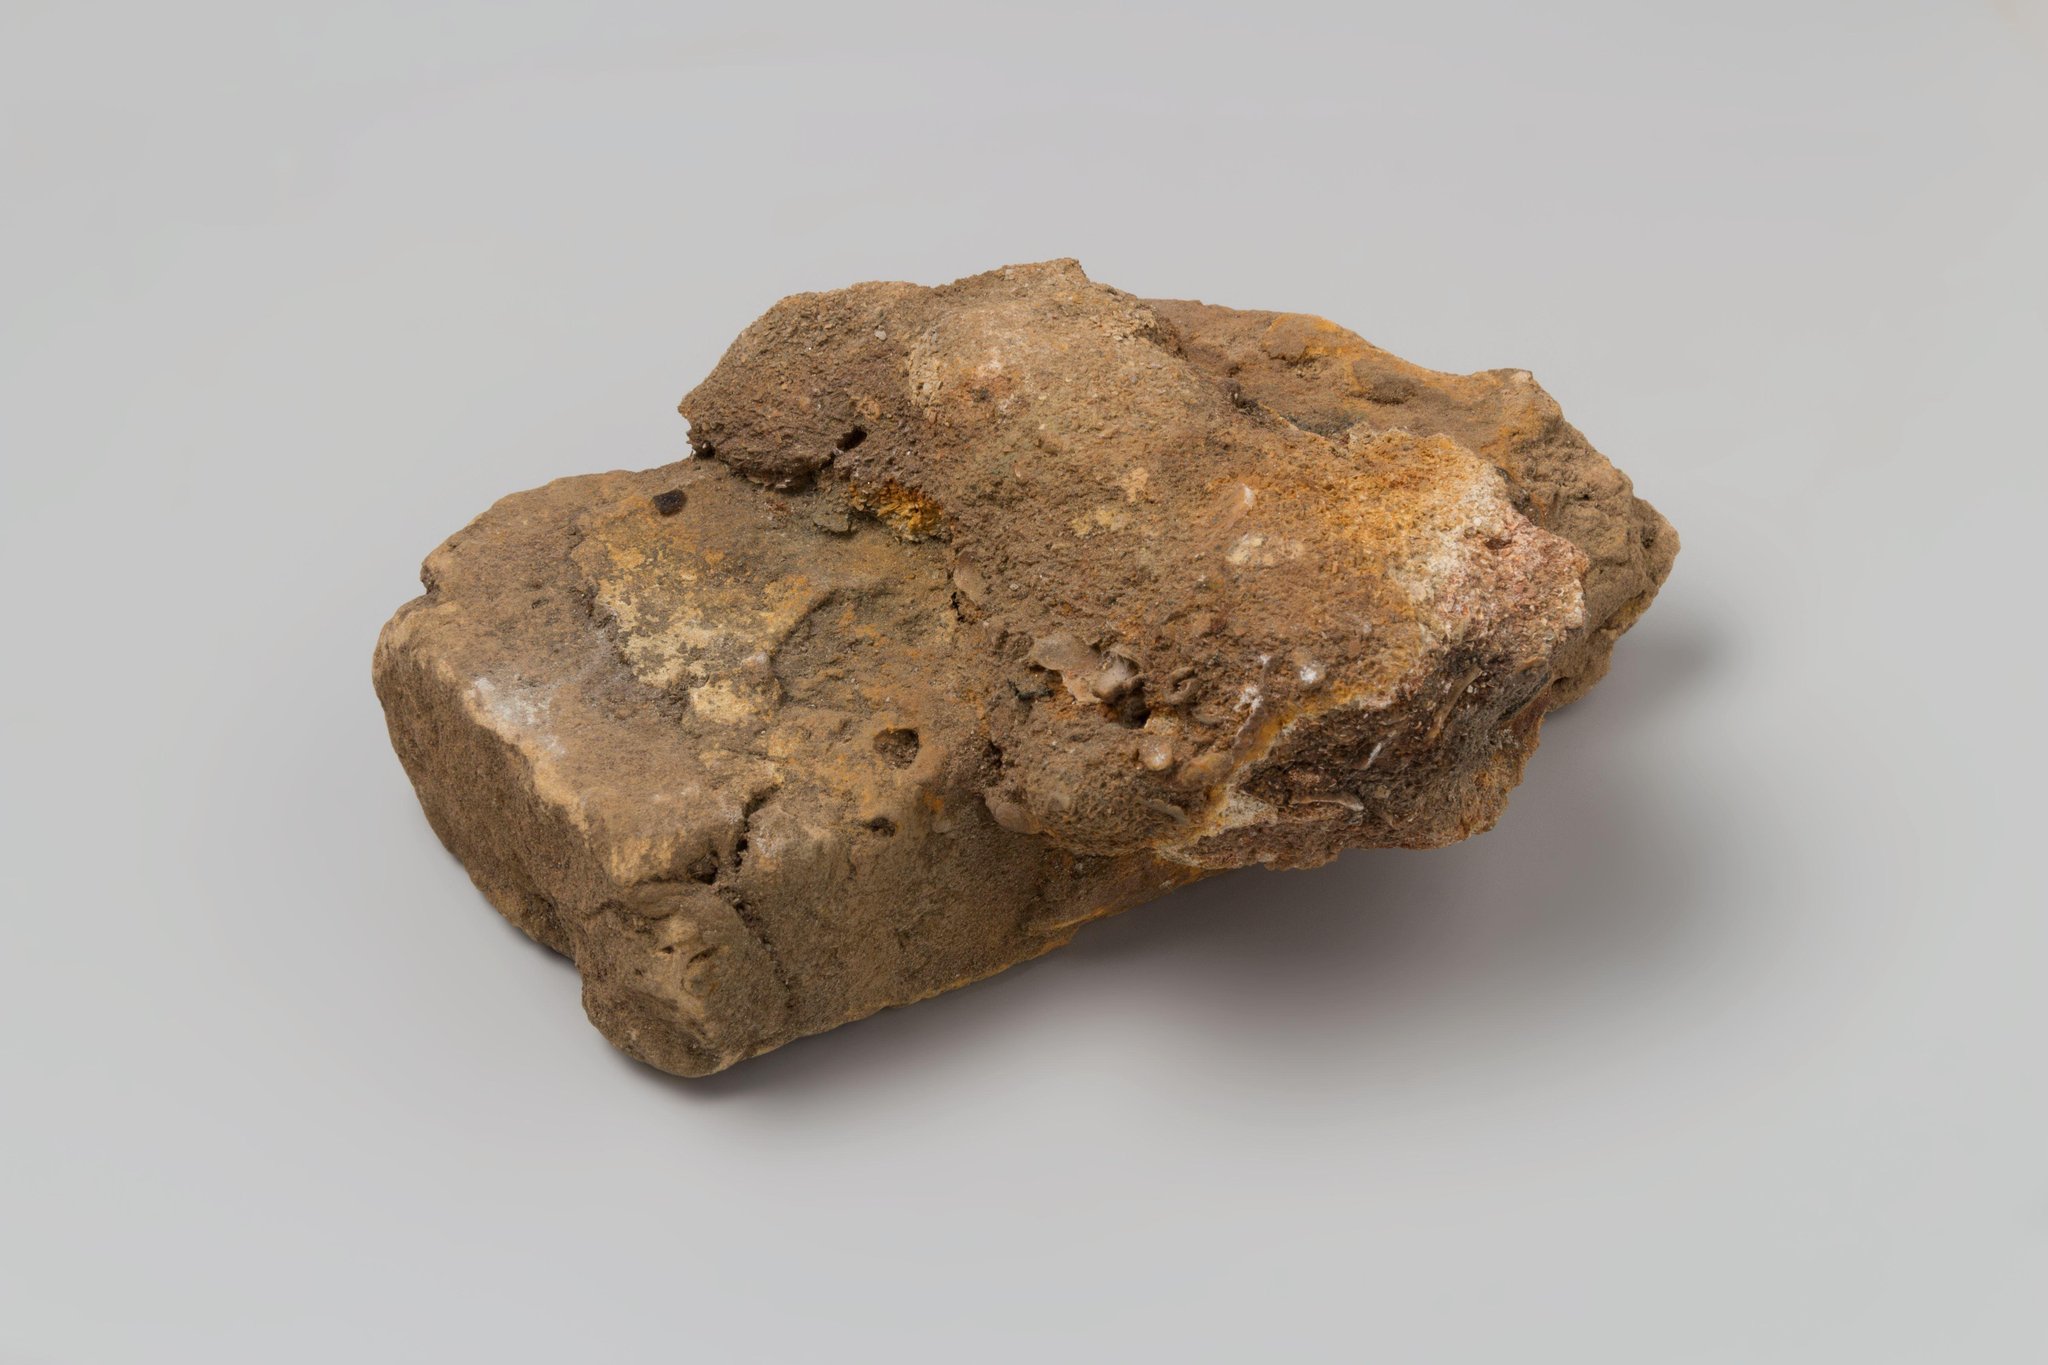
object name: brick clay product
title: Deel van een baksteen met een stuk concretie uit het wrak van de Oost-Indiëvaarder 't Vliegend Hart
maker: Anonymous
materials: brick, stone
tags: 't vliegend hart (schip), verenigde oostindische compagnie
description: Deel van een rechthoekige, geelbruine baksteen met een stuk concretie. Brick.